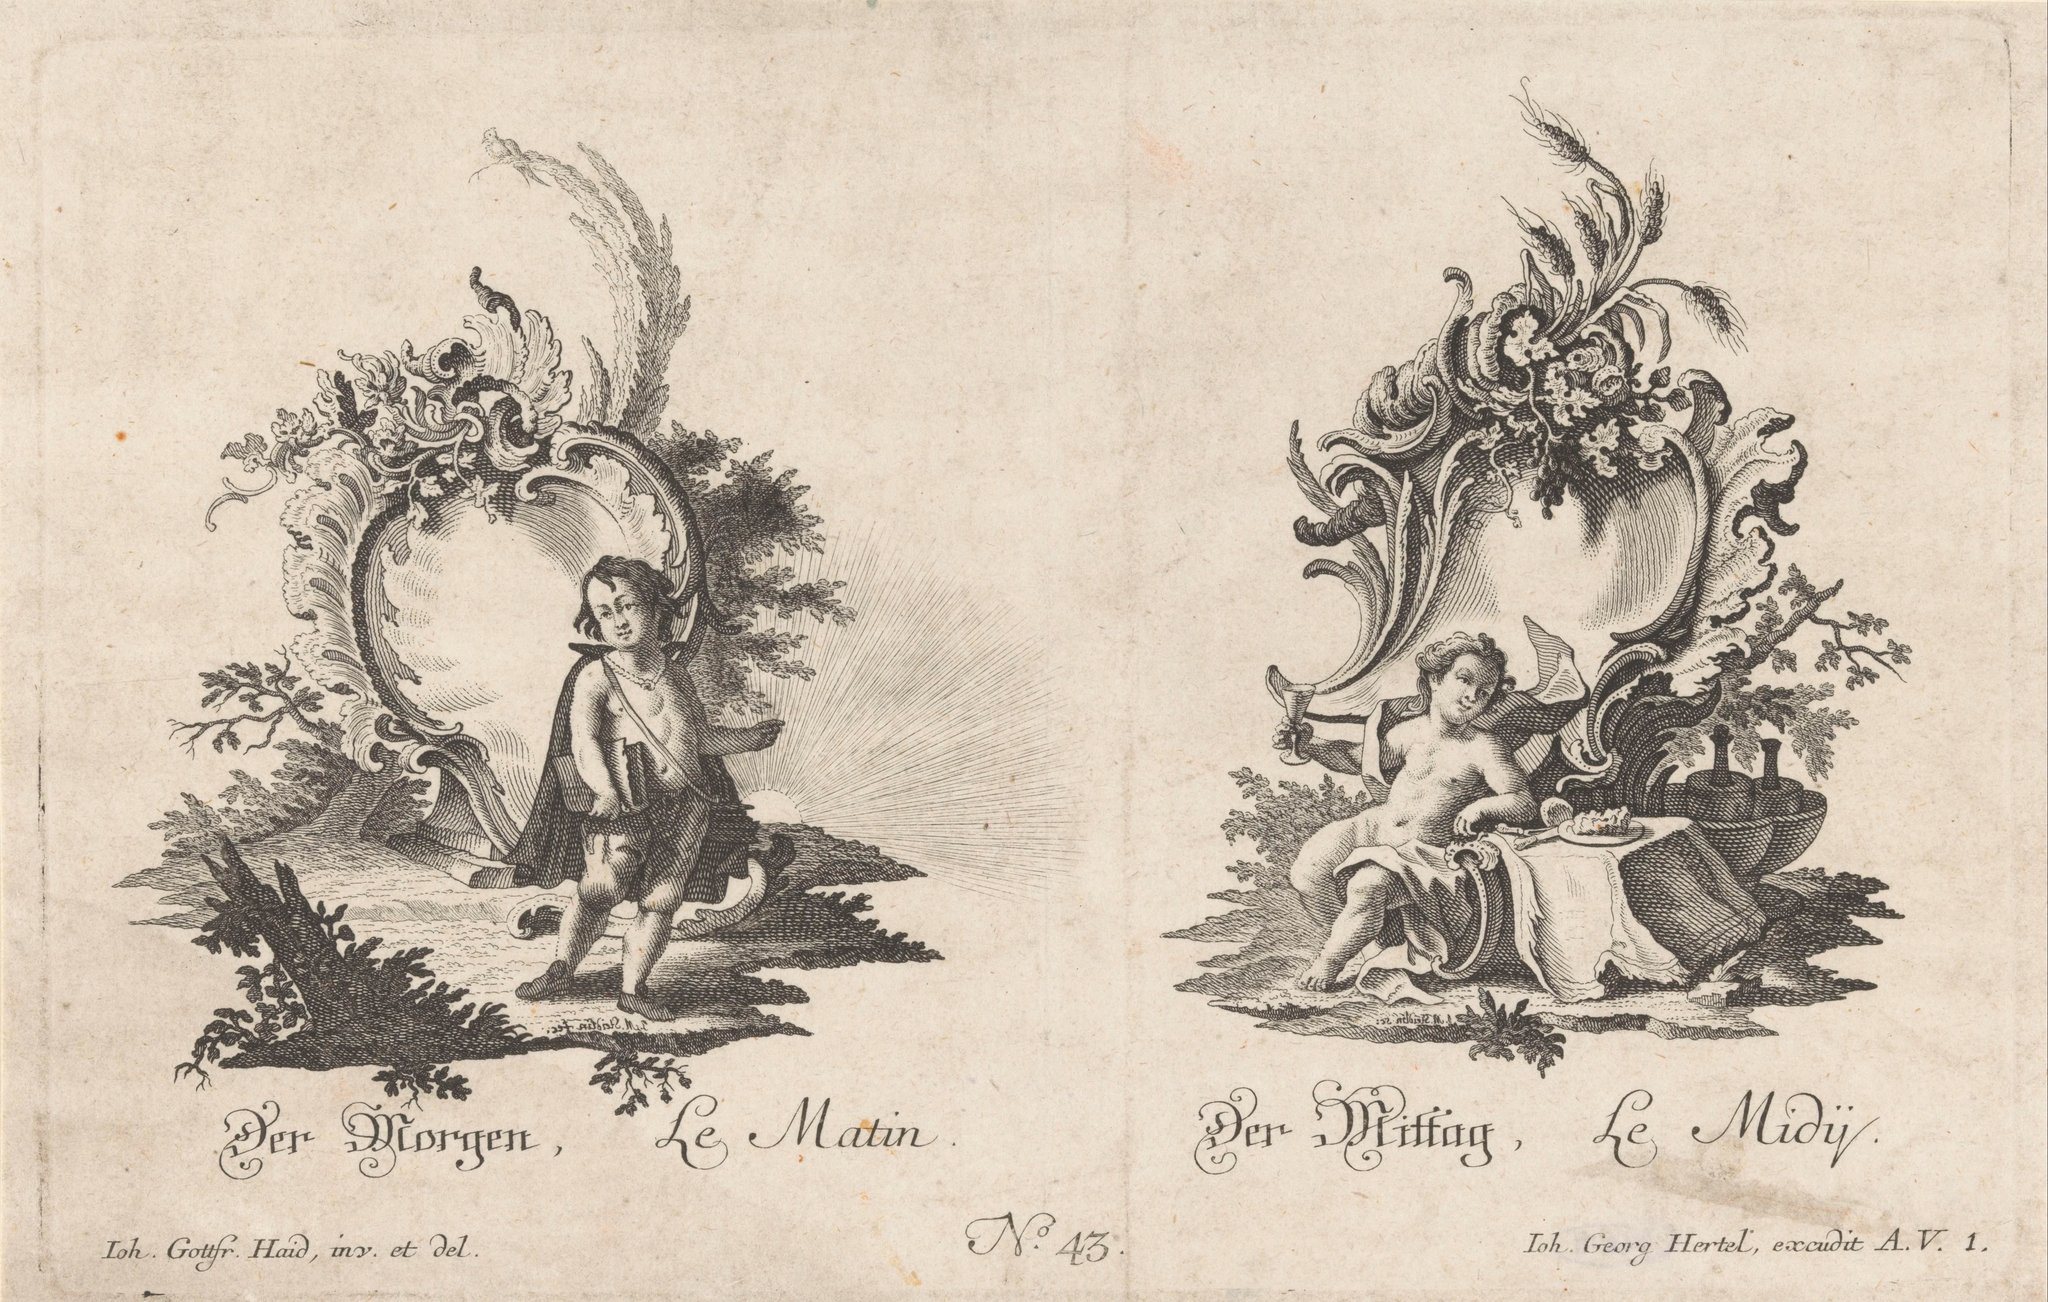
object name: print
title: Tijden van de dag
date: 1720-1775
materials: paper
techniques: etching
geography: augsburg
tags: personification of the morning, 'aurora'; 'aurora' (ripa), personification of the afternoon, 'meridies'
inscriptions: collector's mark: Lugt 2228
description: Personificaties van de ochtend en de middag, met rocaille ornamenten. Links de ochtend, een figuur loopt door een landschap, op de achtergrond de zonsopkomst. Rechts de middag, een figuur in een landschap zit aan tafel te lunchen. Uitgeversnummer 43.